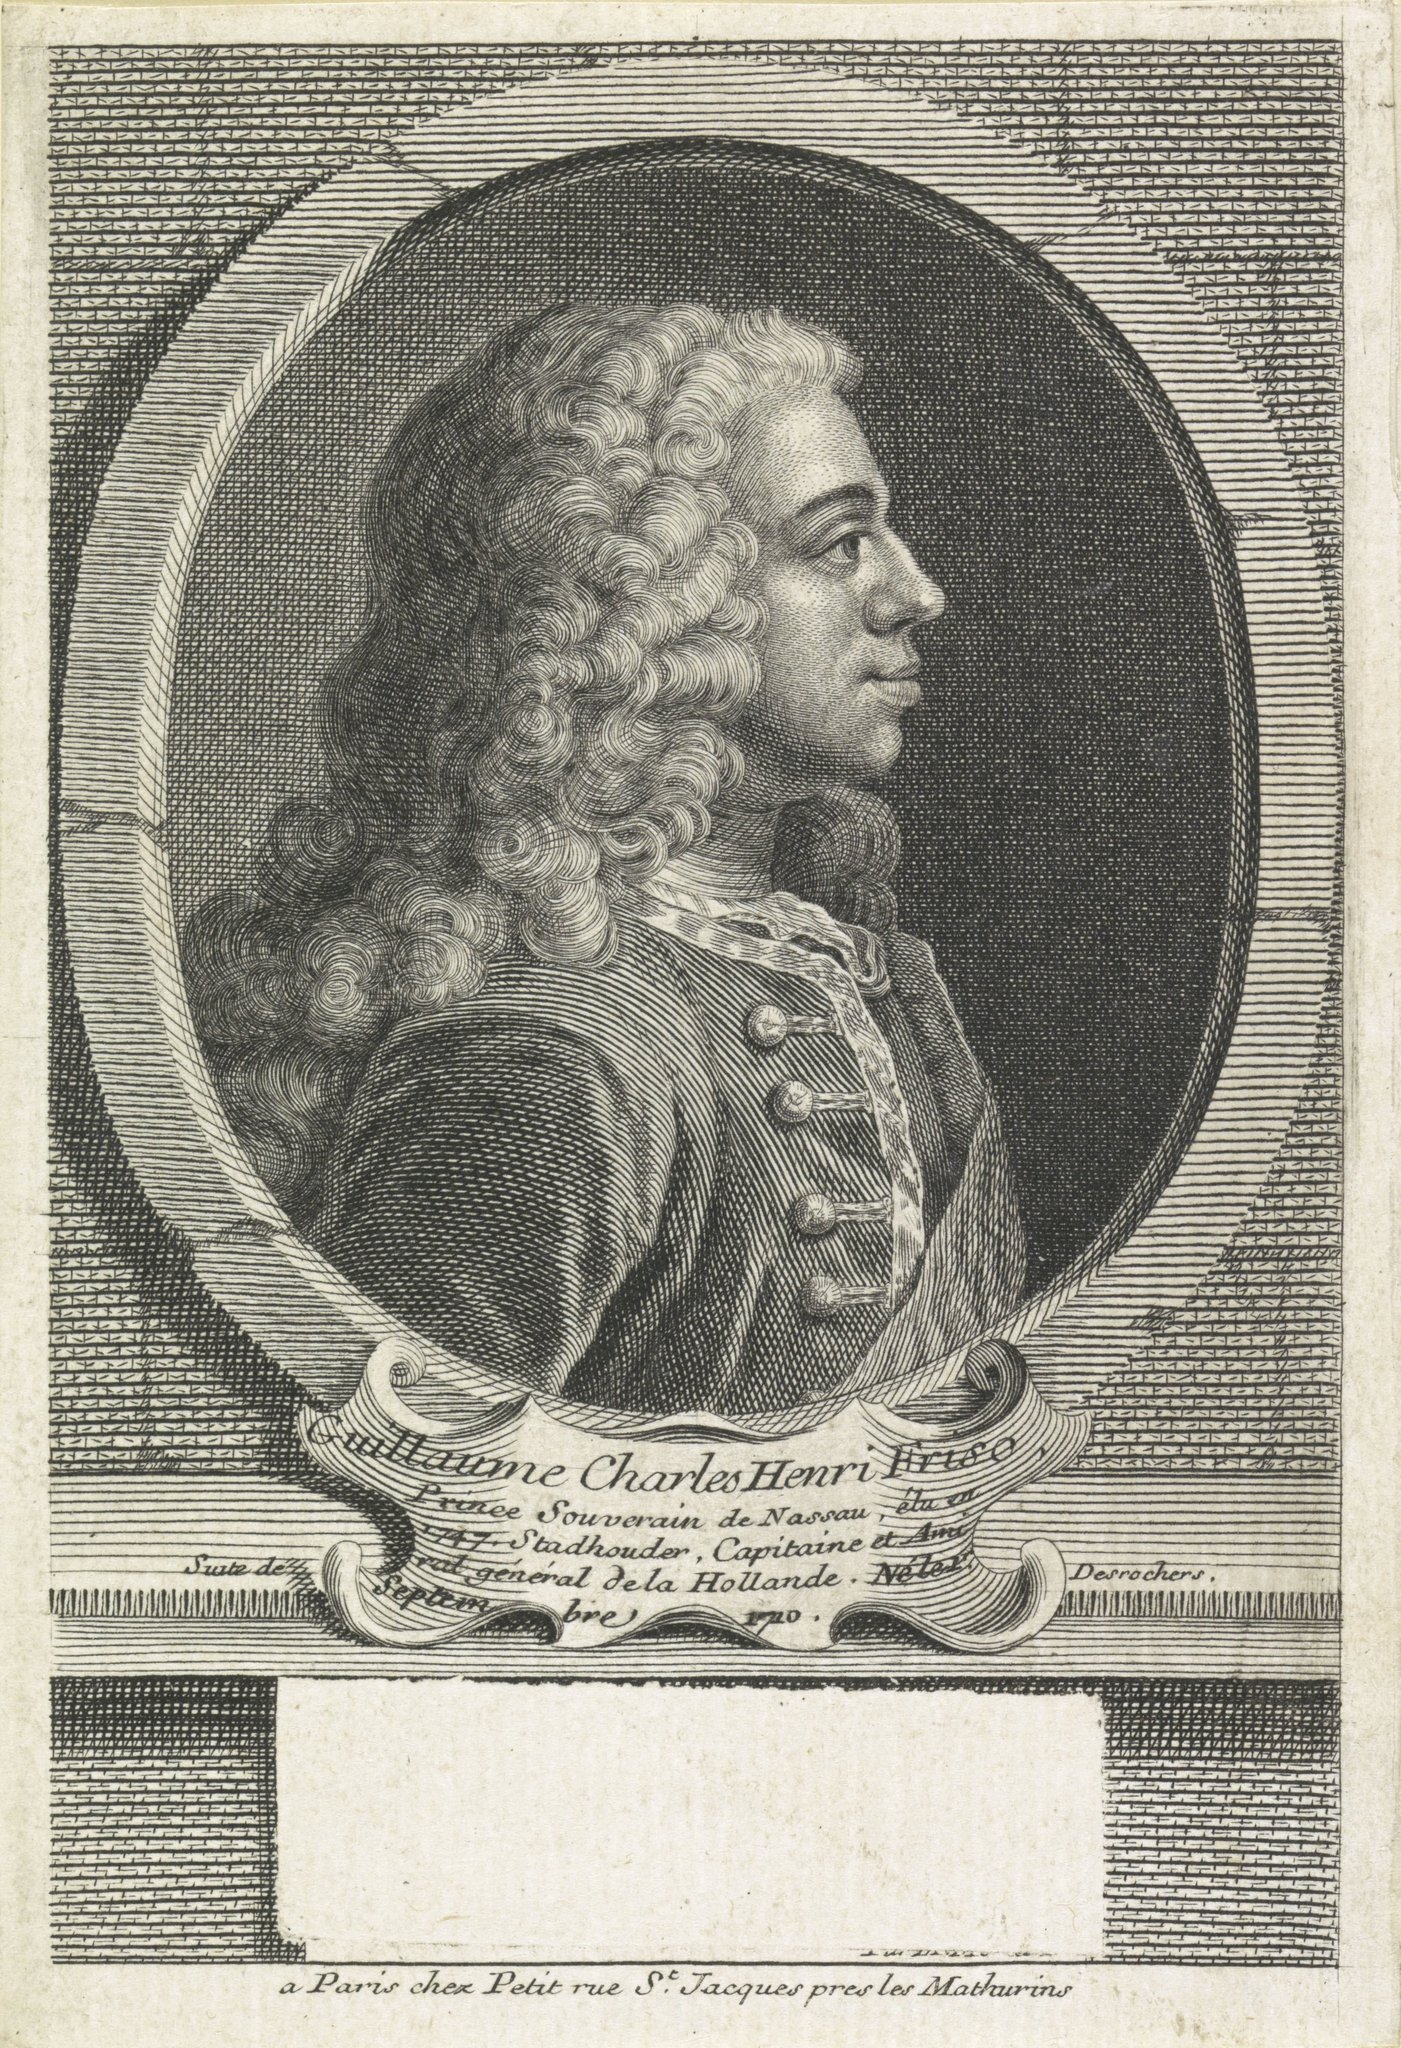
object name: print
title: Portret van Willem IV, prins van Oranje-Nassau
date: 1747-1799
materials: paper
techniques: engraving, etching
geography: paris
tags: the hague, willem iv (prins van oranje-nassau)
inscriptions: collector's mark: Lugt 963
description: De hier vermelde titel verwijst naar de hoogst verkregen titel van de geportretteerde, niet per se naar de titel die de geportretteerde op deze voorstelling draagt.